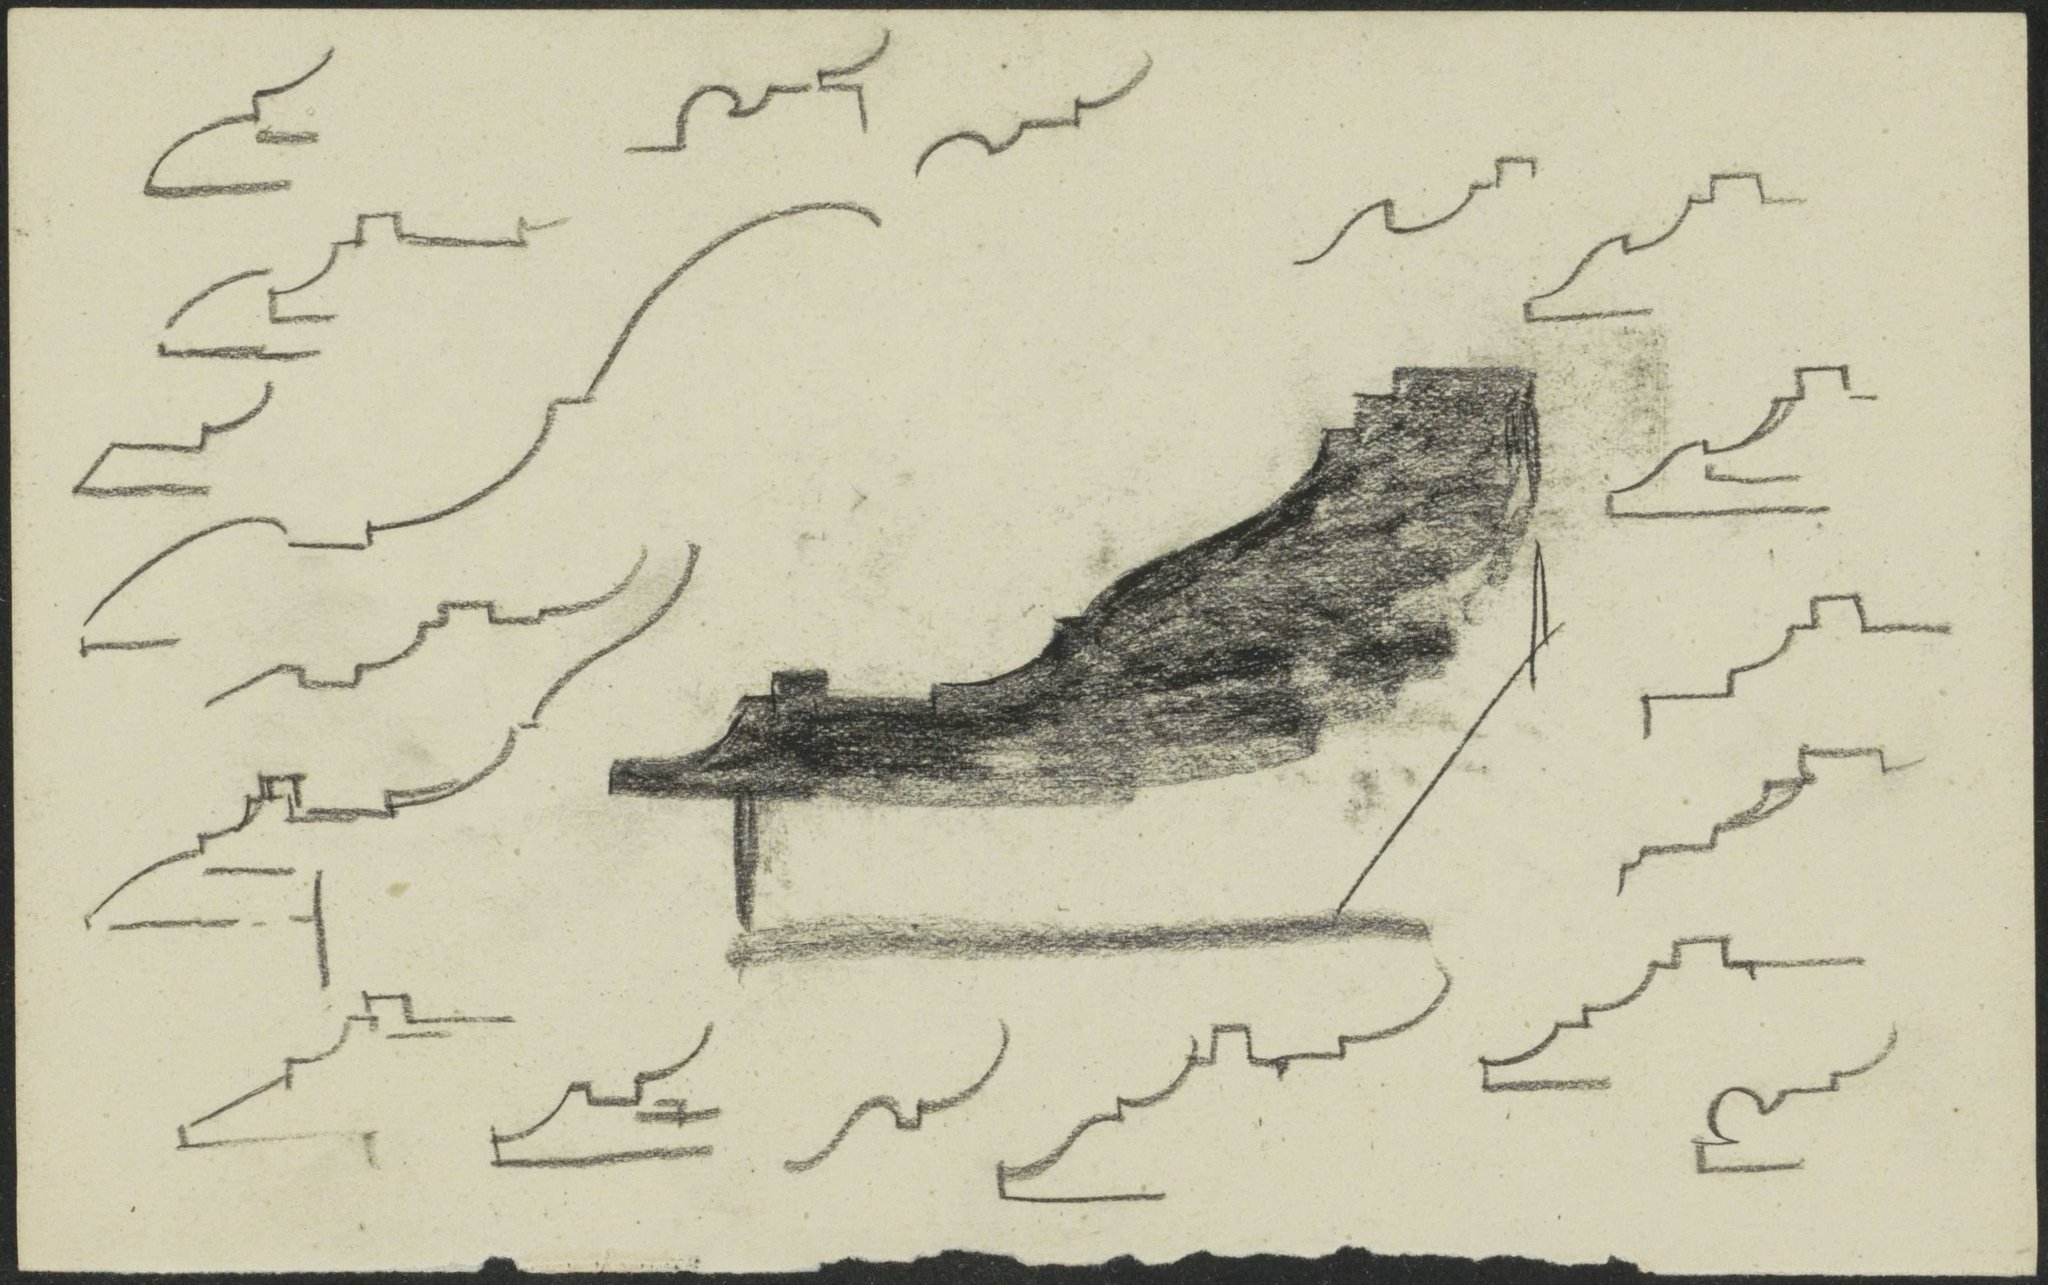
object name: drawing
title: Doorsneden van lijsten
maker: gerrit willem dijsselhof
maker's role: designer, draughtsman, print maker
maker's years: 1866-1924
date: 1876-1924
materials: chalk, paper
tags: frame of painting, etc.